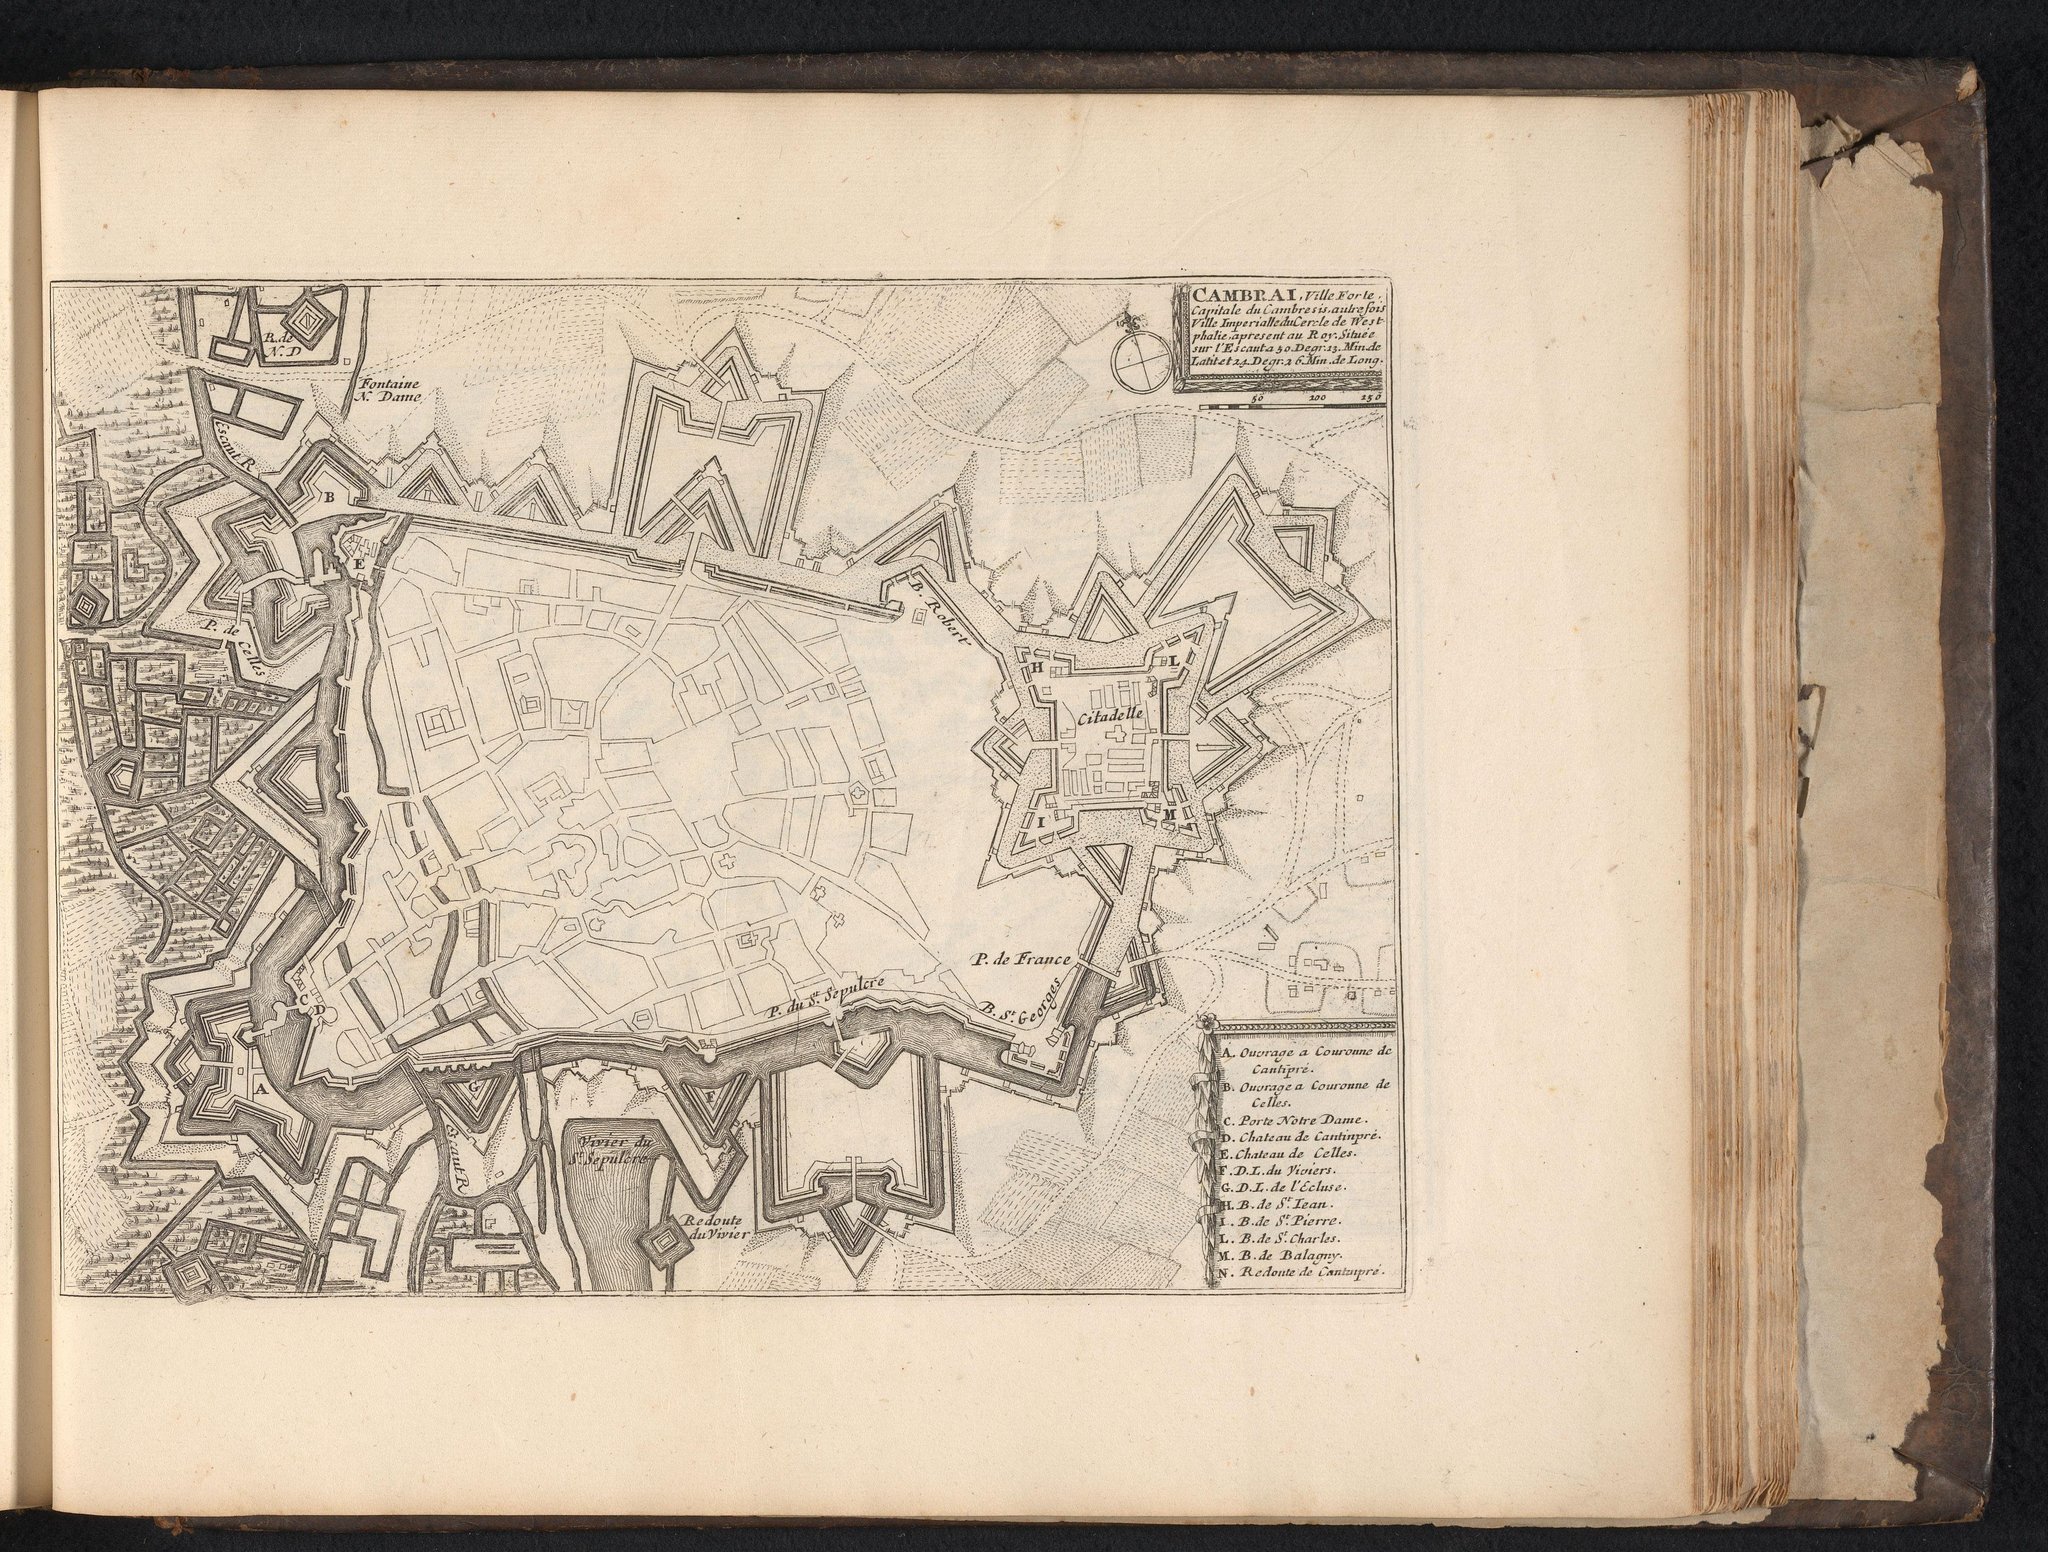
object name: map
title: Le theatre de la guerre, dans les Pays-Bas, ou representation des principales villes qui sont en Flandre, Hainaut, Brabant, et c. : avec leurs fortifications : dessignées par les meilleurs ingenieurs, particulierement celles (...) dont les plans ont esté levez par M. de Vauban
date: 1693-1696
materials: paper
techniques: etching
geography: france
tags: fortress, maps of cities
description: Plattegrond van de versterkingen om de stad Cambrai (Kamerijk), in de graafschap Henegouwen. Onderdeel van het eerste van twee delen van het prentwerk: Le Theatre de la Guerre, dans les Pays-Bas, waarvan het titelblad uitgegeven is in 1696. Het prentwerk bestaat in totaal (beide delen) uit 52 platen met plannen (afkomstig van Sébastien Le Prestre, Seigneur de Vauban) van vermaarde sterke steden en vestingen in de Negenjarige Oorlog in de Nederlanden. Identiek aan de plaat die voorkomt in: Les forces de l'Europe, uitgegeven tussen 1693-1697. Titel en opschriften in het Frans.